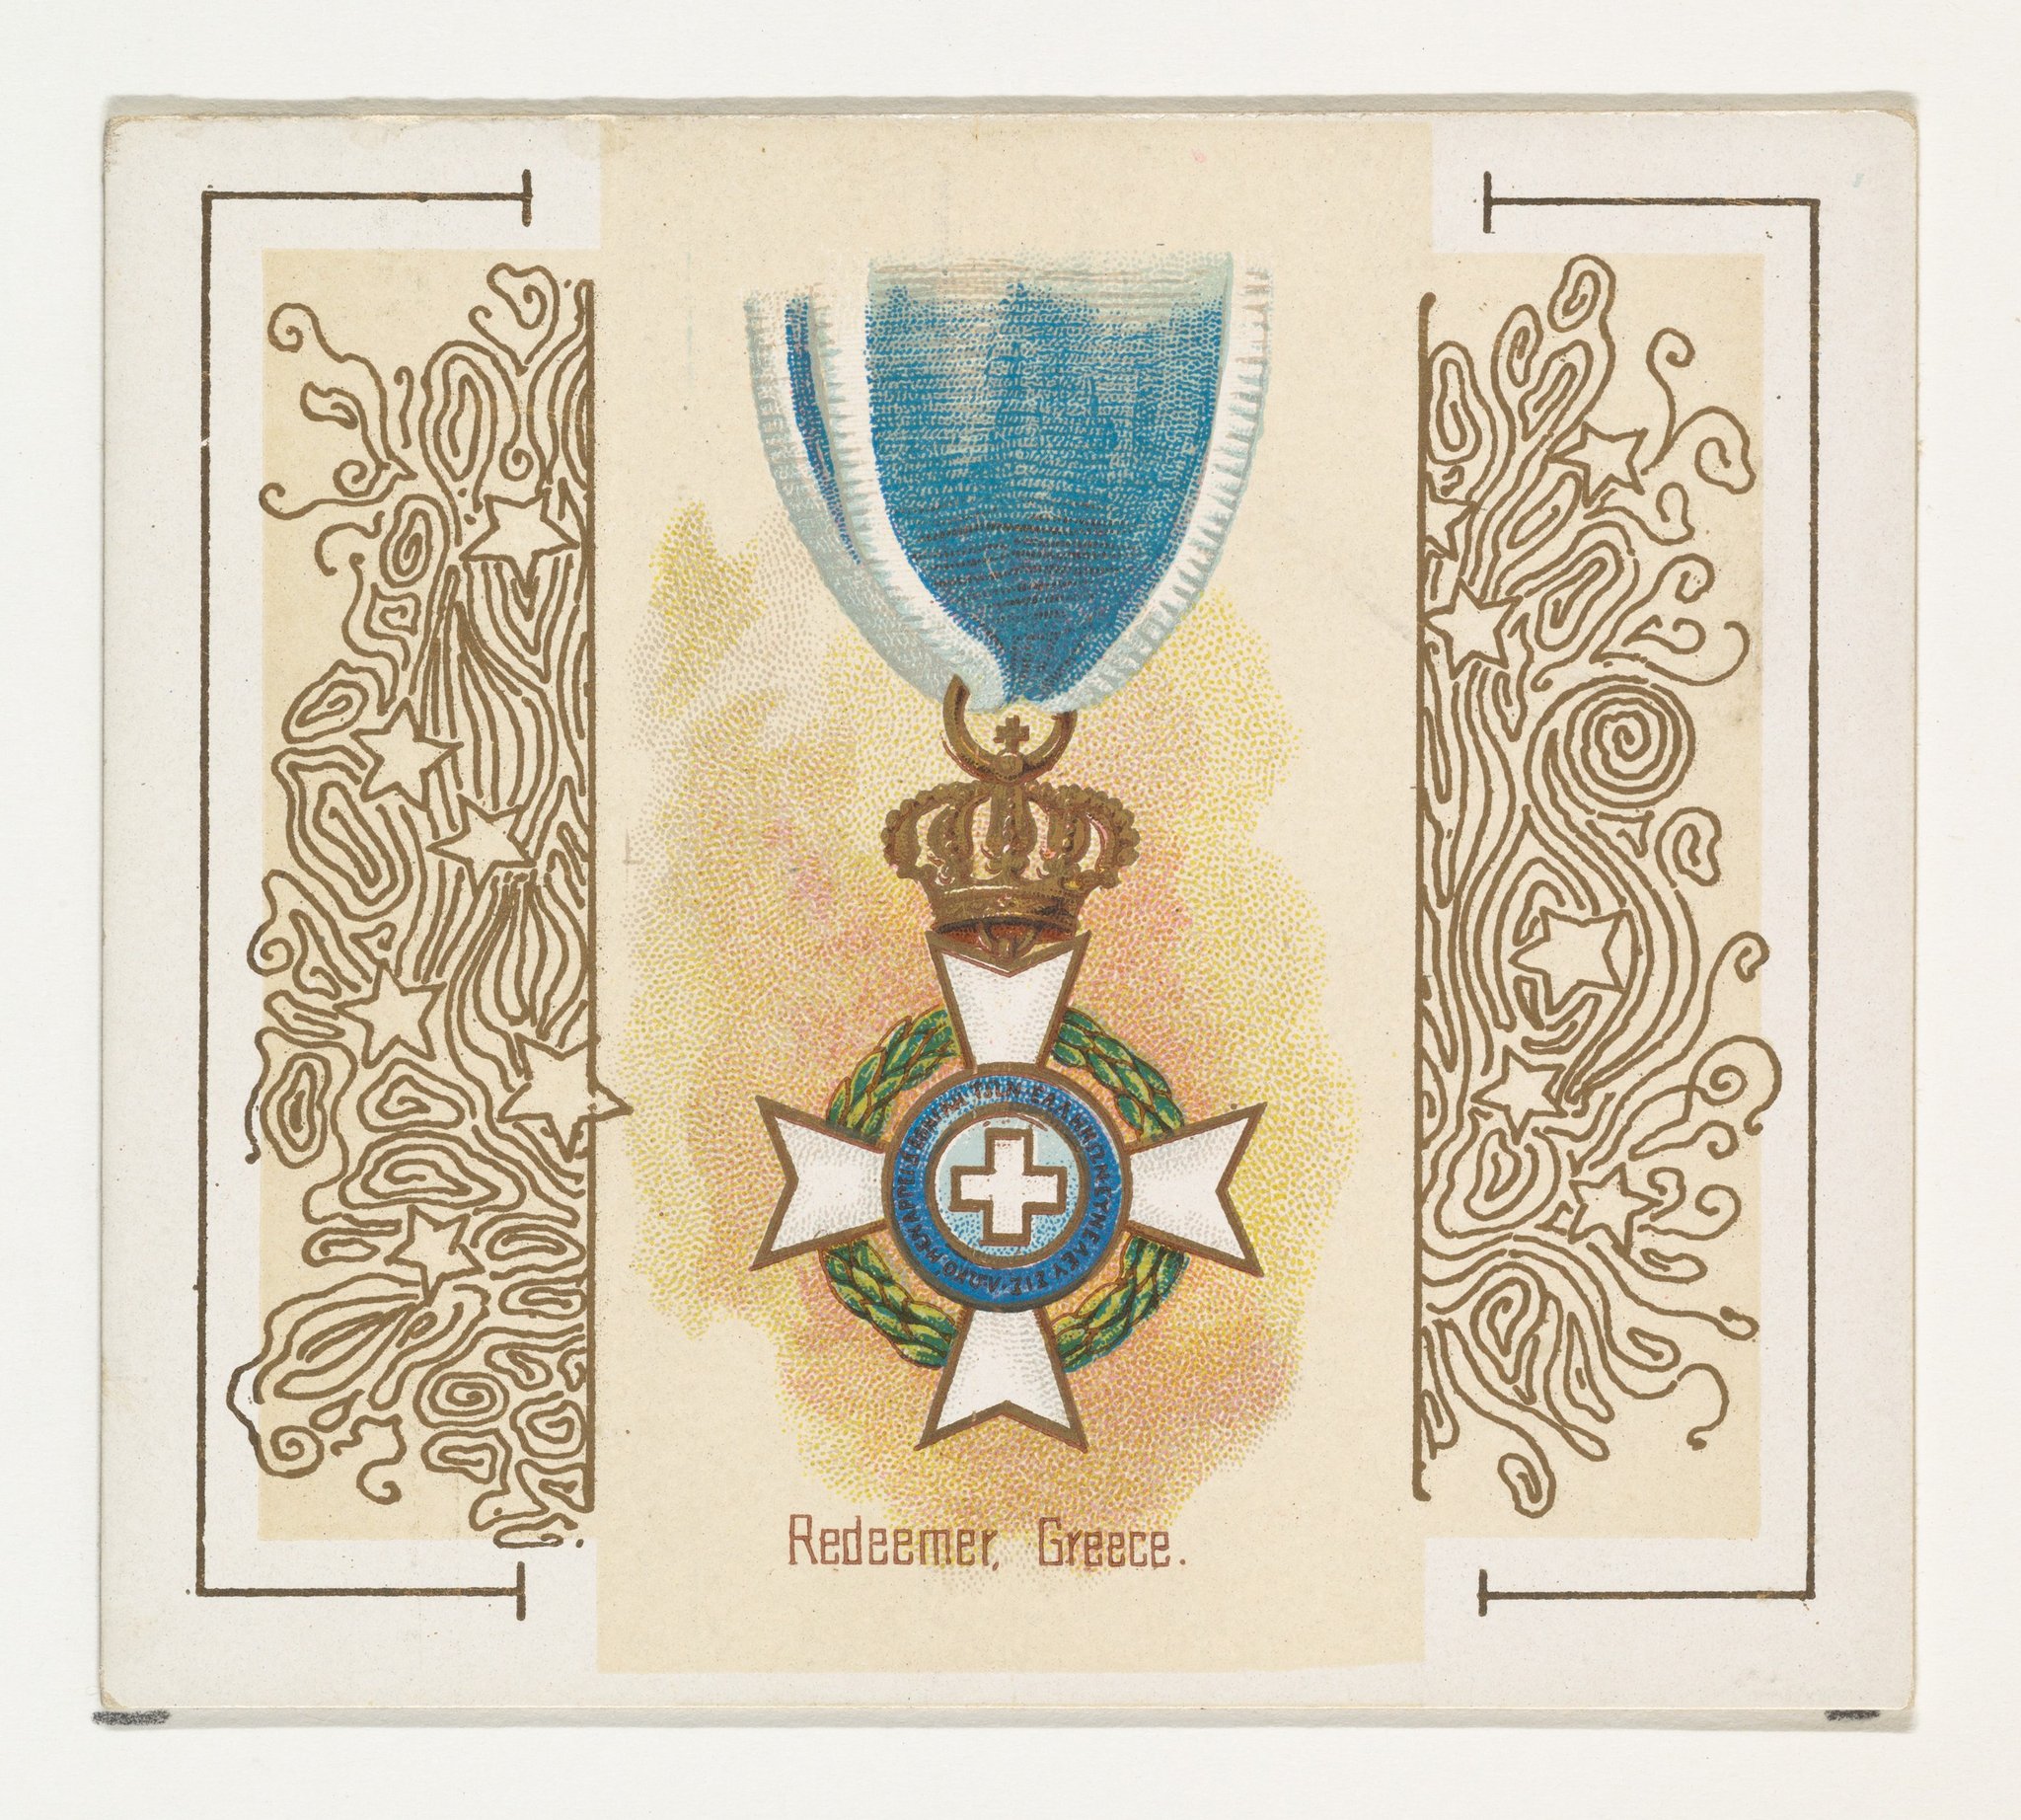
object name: print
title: Redeemer, Greece, from the World's Decorations series (N44) for Allen & Ginter Cigarettes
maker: allen & ginter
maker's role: publisher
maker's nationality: american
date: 1890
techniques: color lithograph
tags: medals